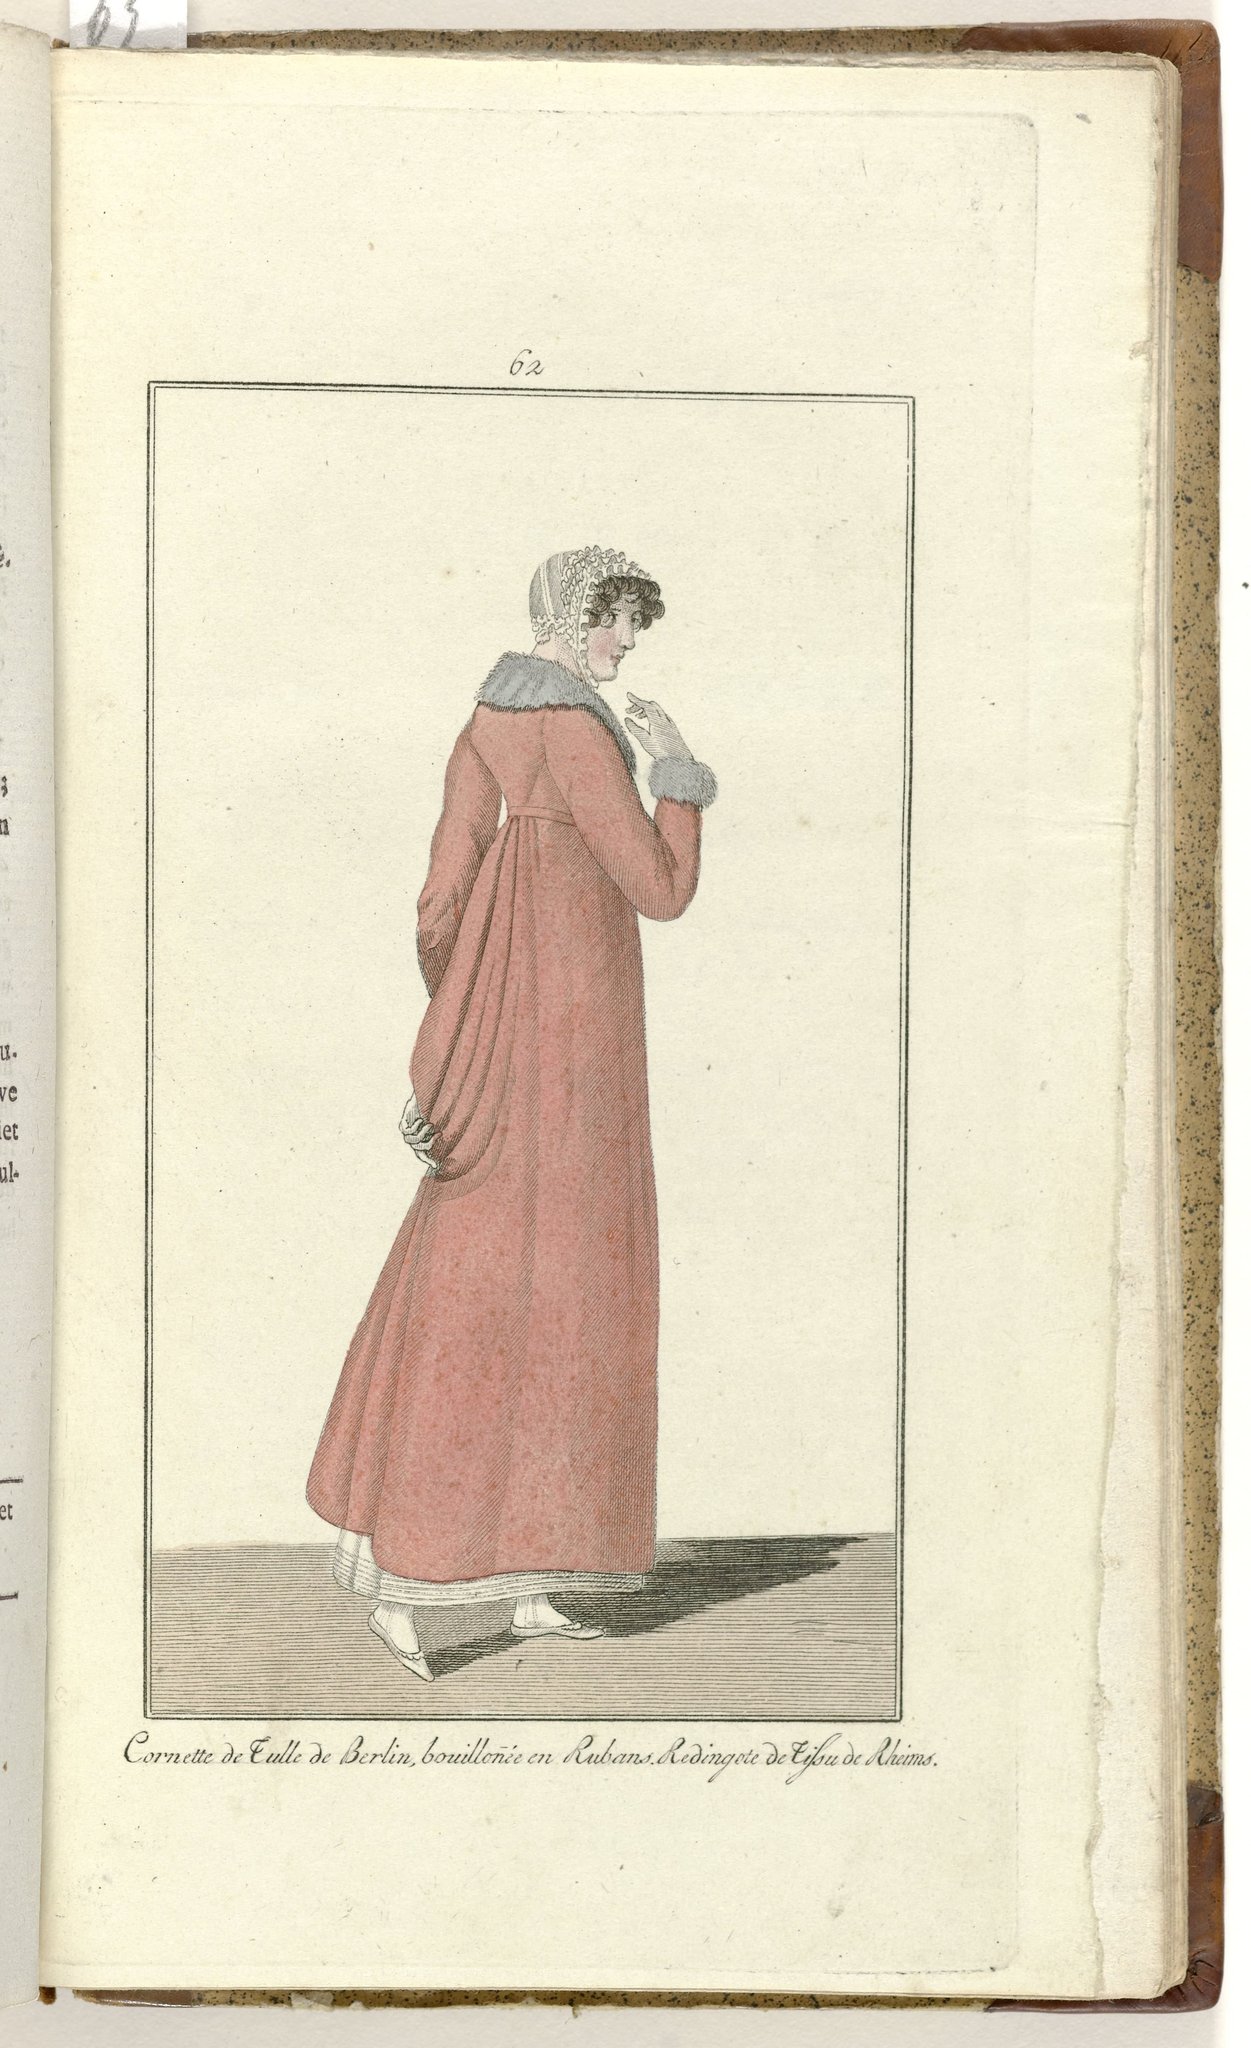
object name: magazine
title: Elegantia, of tijdschrift van mode, luxe en smaak voor dames, November 1808, No. 62 : Cornette de Tulle de Berlin...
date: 1808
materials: paper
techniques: engraving, hand coloring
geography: amsterdam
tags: border, ribbon, braid (+ women's clothes), dress, gown: redingote (+ women's clothes), head-gear: cap (+ women's clothes), fashion plates, neck-gear: collar (+ fur used for clothes)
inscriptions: caption: ‘Cornette de Tulle de Berlin, bouillonnée en Rubans. Redingote de Tissu de Rheims.’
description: Volgens de begeleidende tekst (p. 352): 'Cornette van 'tulle de Berlin' met lint gebouillonneerd. Redingote van 'tissu de Rheims' met kraag en manchetten van bont. Prent uit het modetijdschrift Elegantia, of tijdschrift van mode, luxe en smaak voor dames 1807-1814 (onderbroken door de periode 1811-1813).